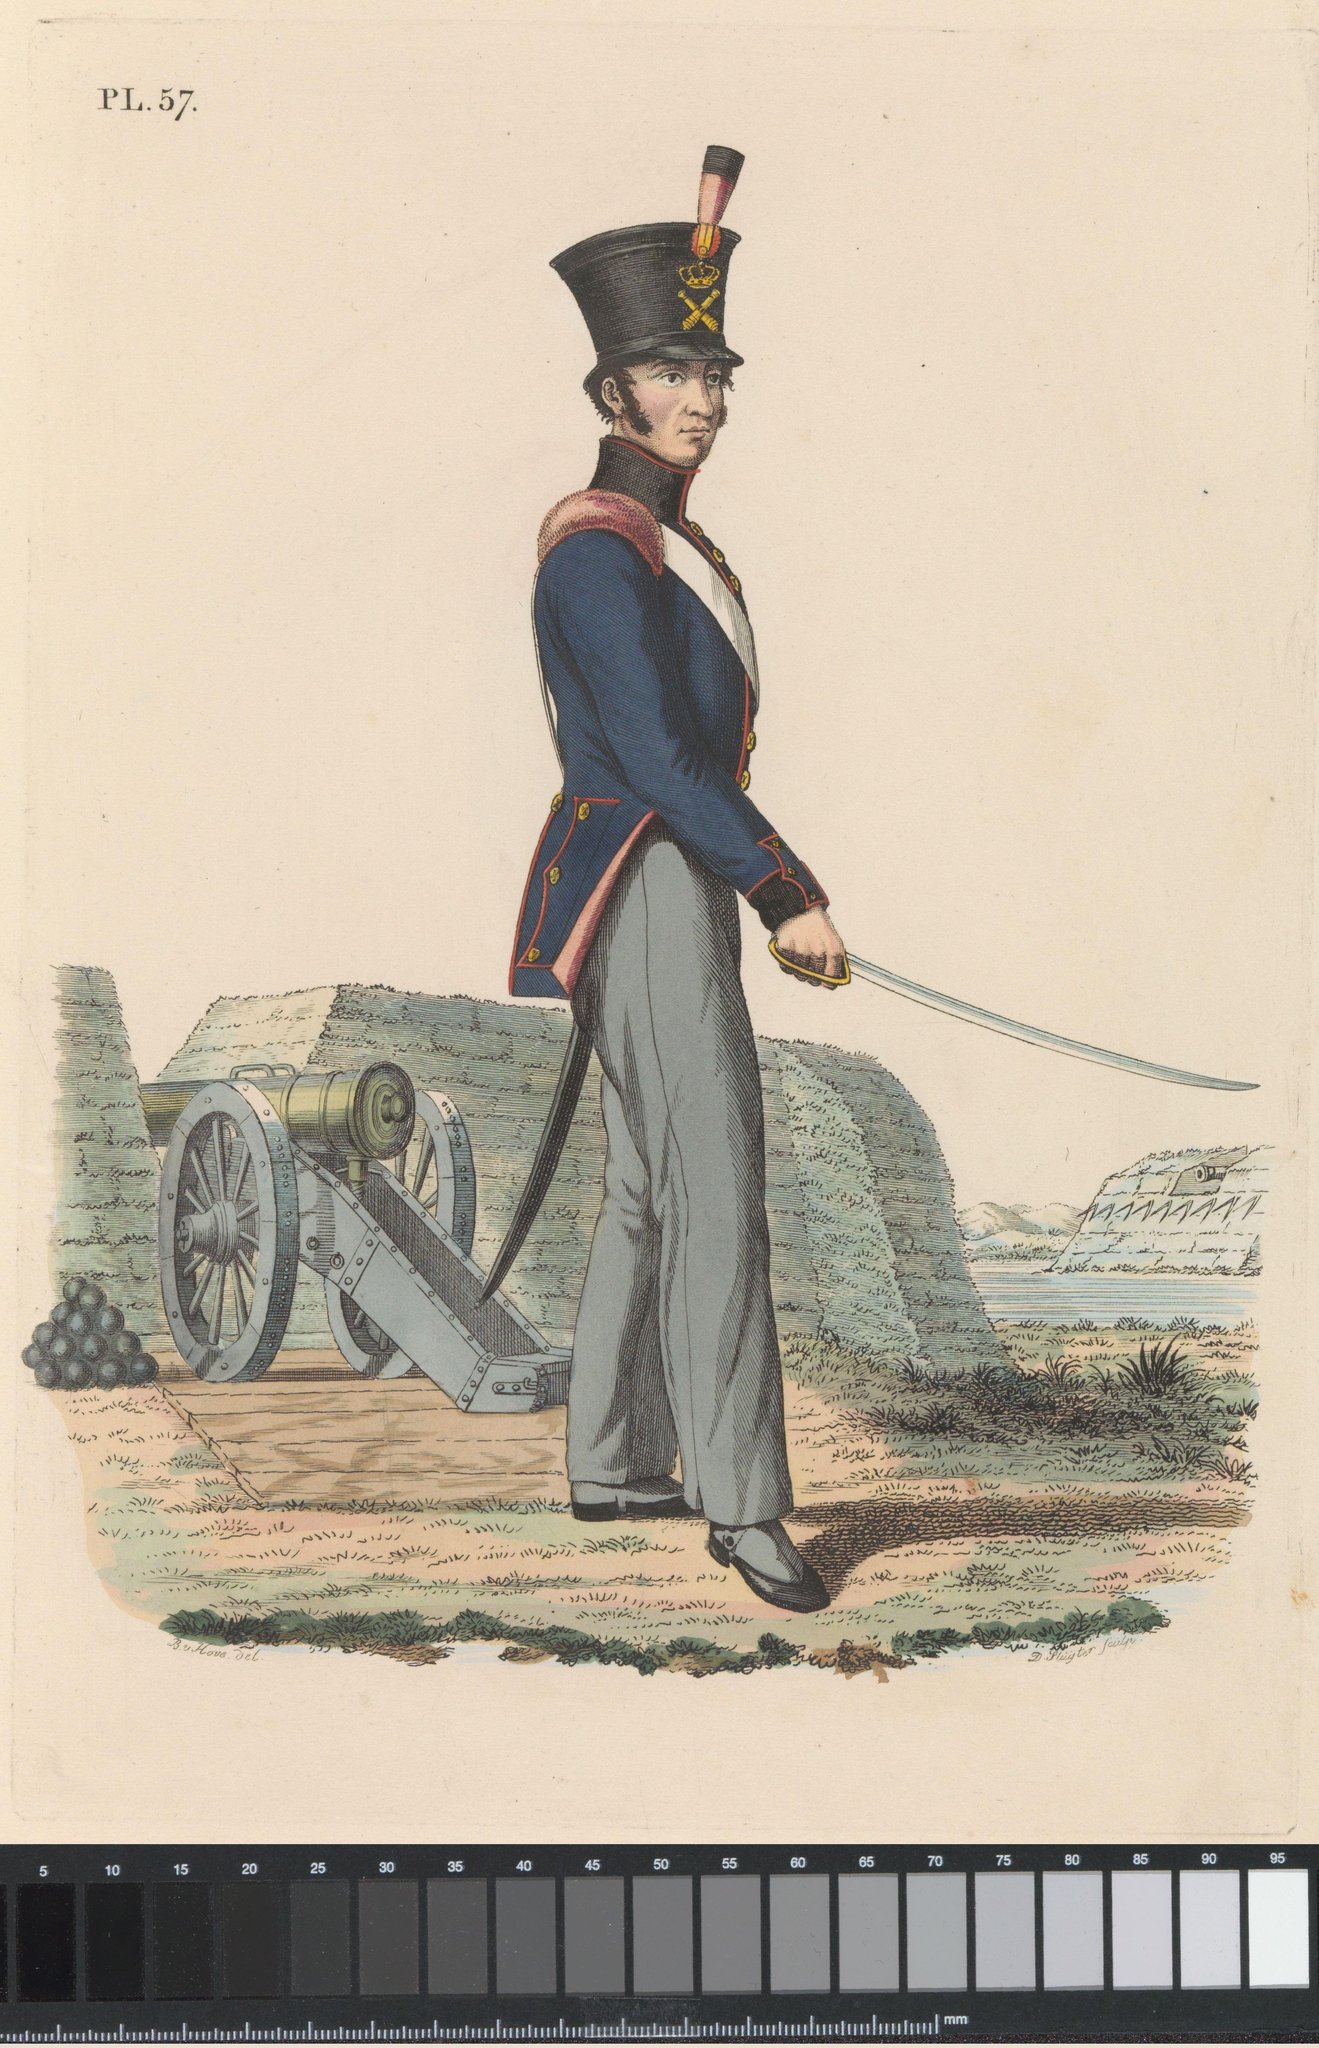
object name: costume print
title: Kanonnier der Artillerie Nationale Militie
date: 1826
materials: paper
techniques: engraving, etching, hand coloring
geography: netherlands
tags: (military) uniforms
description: Een Nederlandse kanonnier van de artillerie van de Nationale Militie. Staande met getrokken sabel, bij een stuk geschut. Plaat 57. Uniformvoorstelling in 'Vervolg van de Beschrijving hoedanig de Koninklijke Nederlandsche troepen' van J.F. Teupken, 1826.